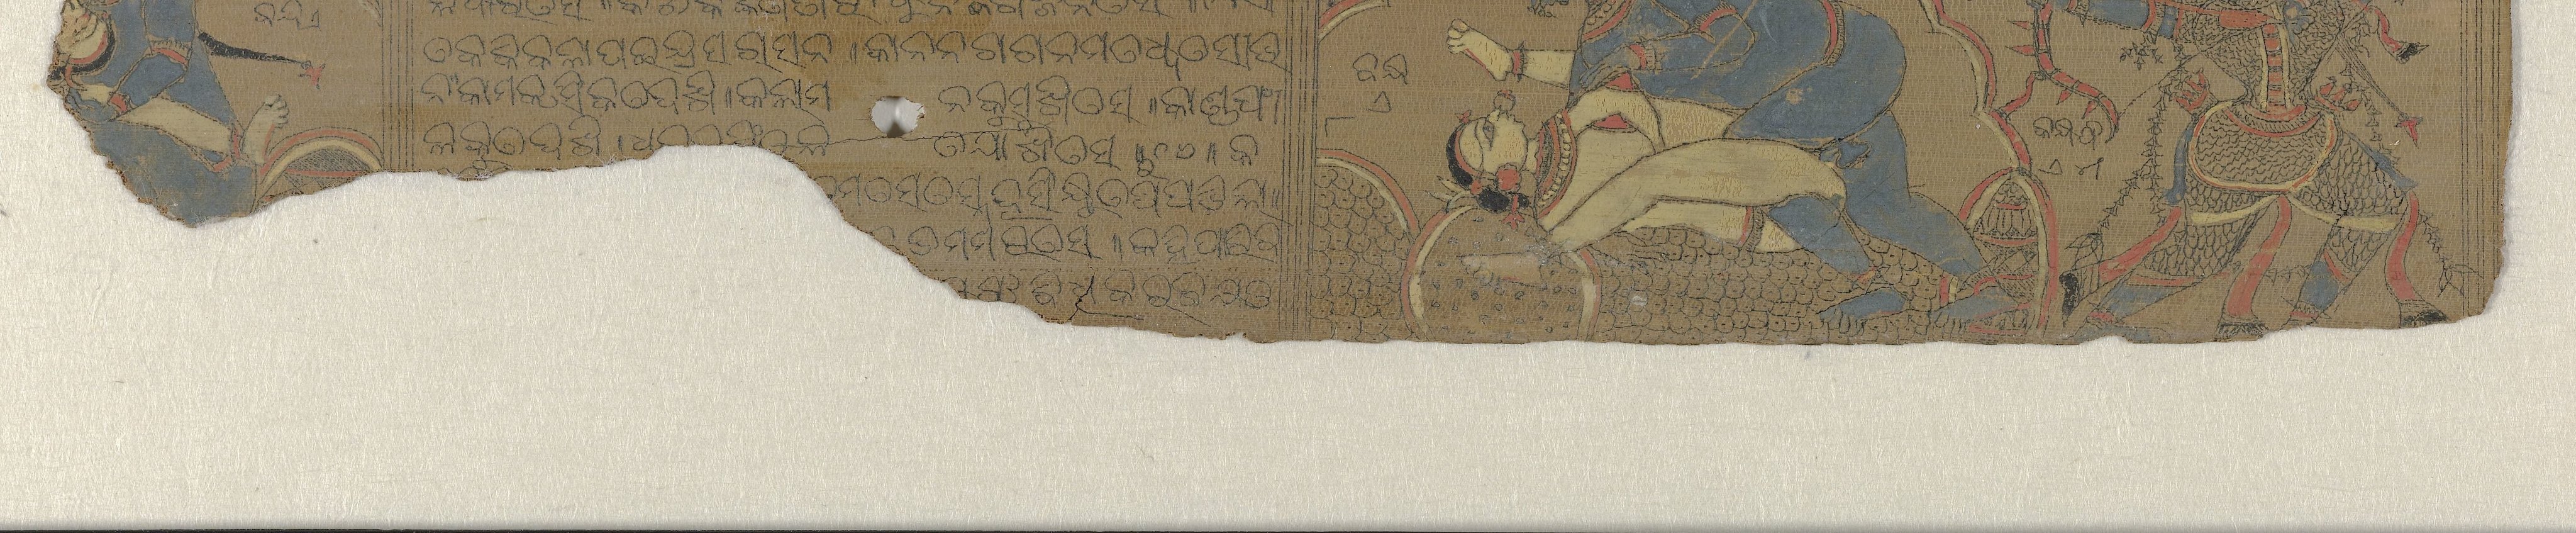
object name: indian miniature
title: Erotische scènes met Krishna en Radha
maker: Anonymous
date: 1700-1800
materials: leaf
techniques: brush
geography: odisha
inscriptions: inscription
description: In het midden een scène waarin Krishna met Radha de liefde bedrijft; rechts Krishna als krijger die een lotuspijl afschiet, links een serie schrifttekens en links daarvan een onvolledige liefdesscène. Het stukje palmblad is in een blauw passepartout opgenomen zodat voor- en achterkant zichtbaar zijn.